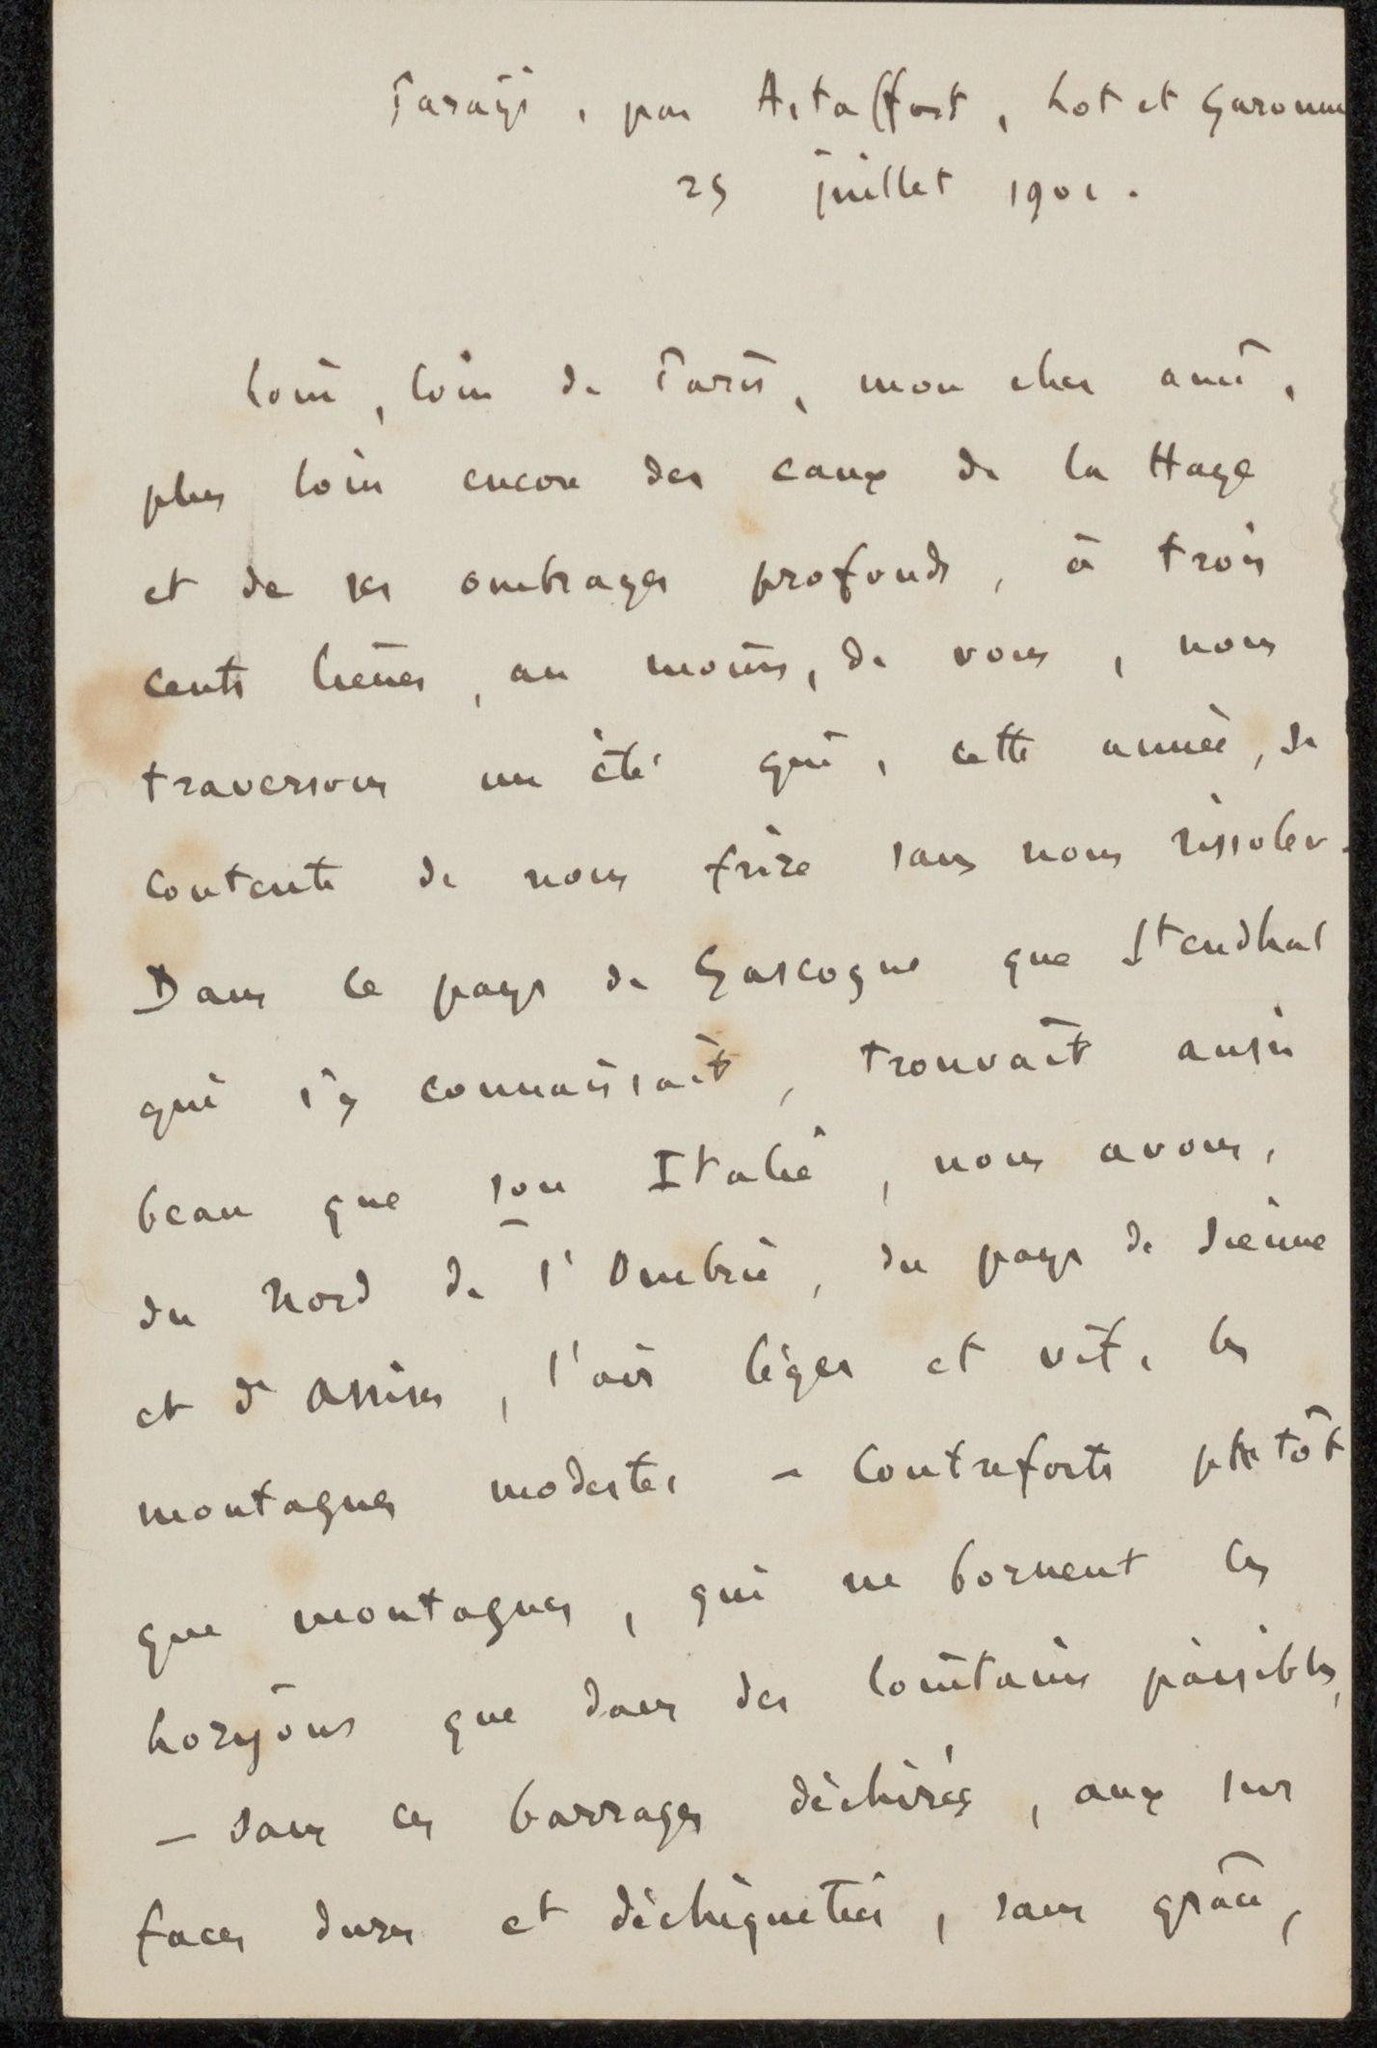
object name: letter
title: Brief aan Philip Zilcken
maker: alidor delzant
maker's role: advocaat, auteur, kunstverzamelaar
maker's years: 1848-1905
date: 1901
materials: ink, paper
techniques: pen, writing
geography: parays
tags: philippe burty, edmond de goncourt, paris, stéphane mallarmé, print maker, félix bracquemond, félicien rops, painter, draughtsman, philip zilcken, literature ~ arts, italy, the hague, france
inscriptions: collector's mark: ‘RPK’